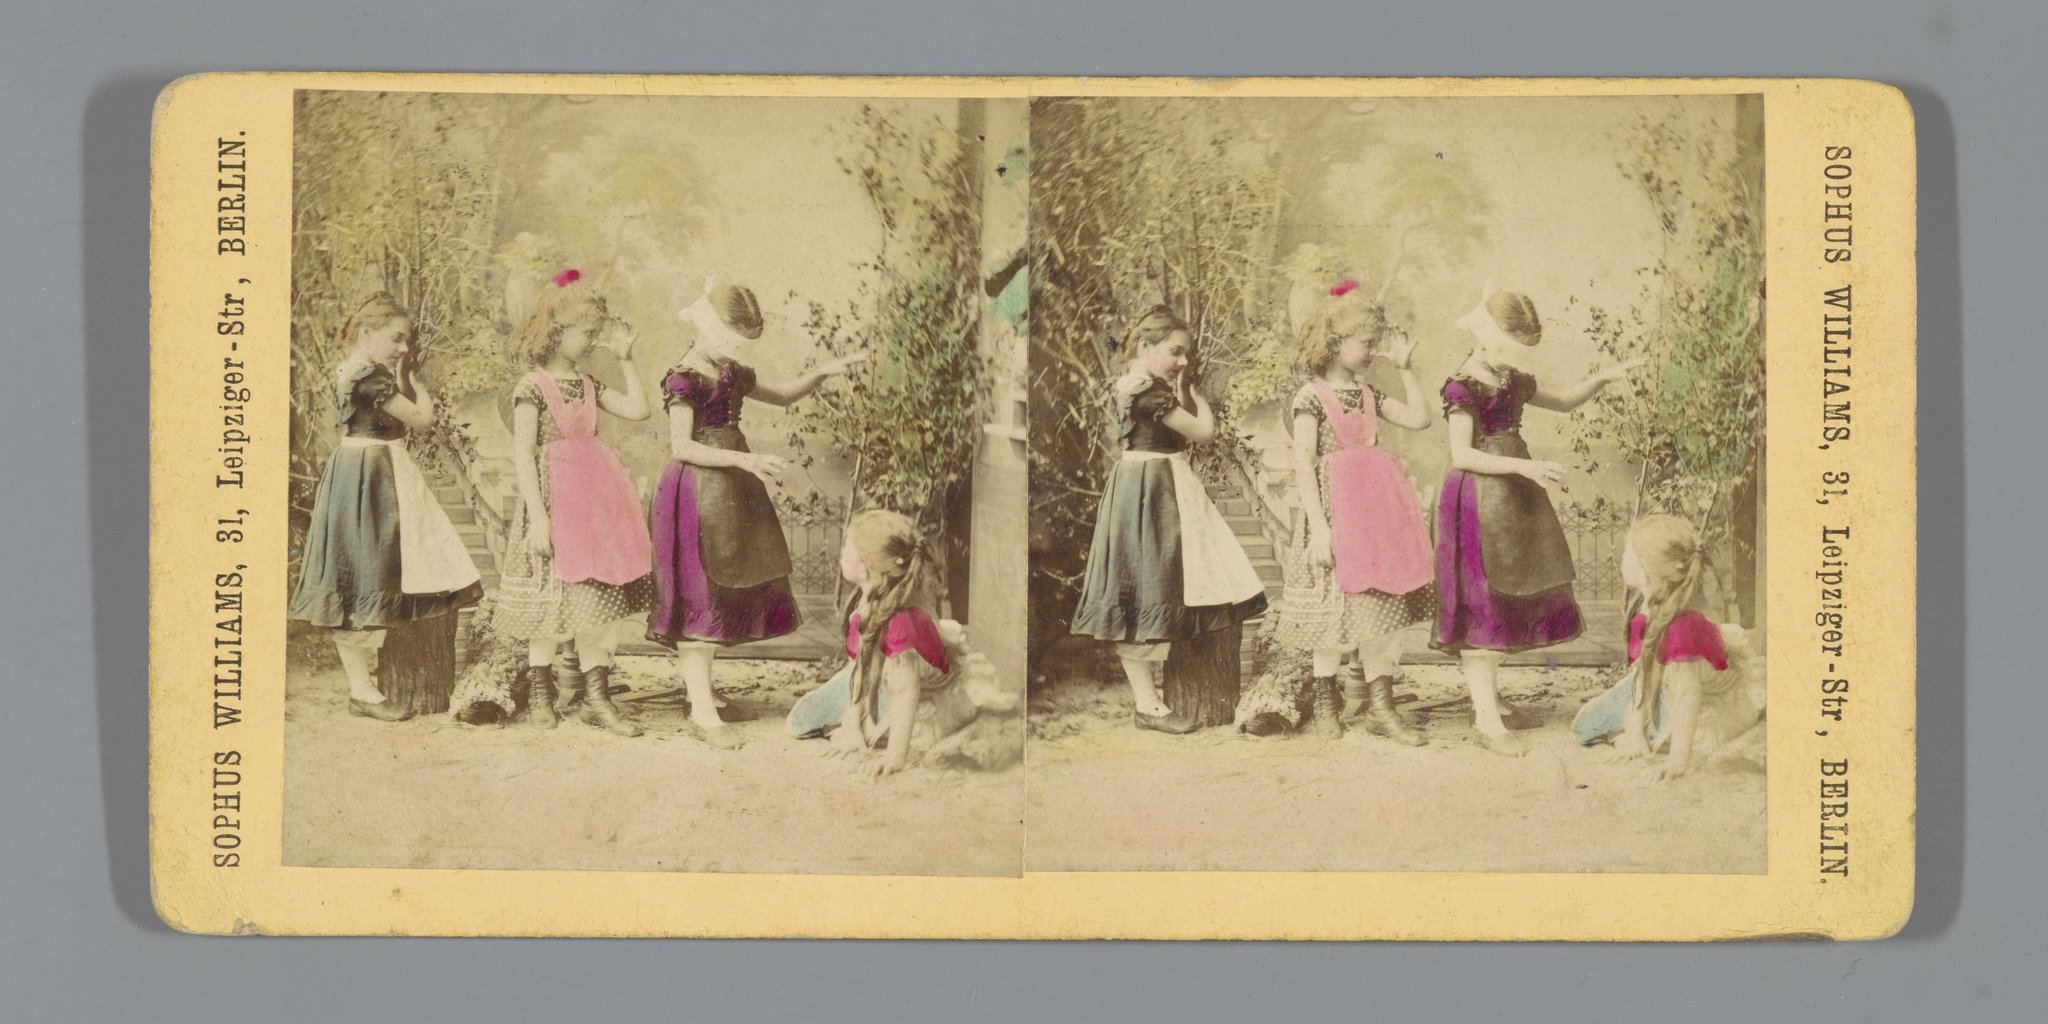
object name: stereograph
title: Vier spelende meisjes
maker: sophus williams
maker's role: publisher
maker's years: 1835-1900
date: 1873-1890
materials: cardboard, paper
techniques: albumen print, hand coloring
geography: berlin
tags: girl (child between toddler and youth)